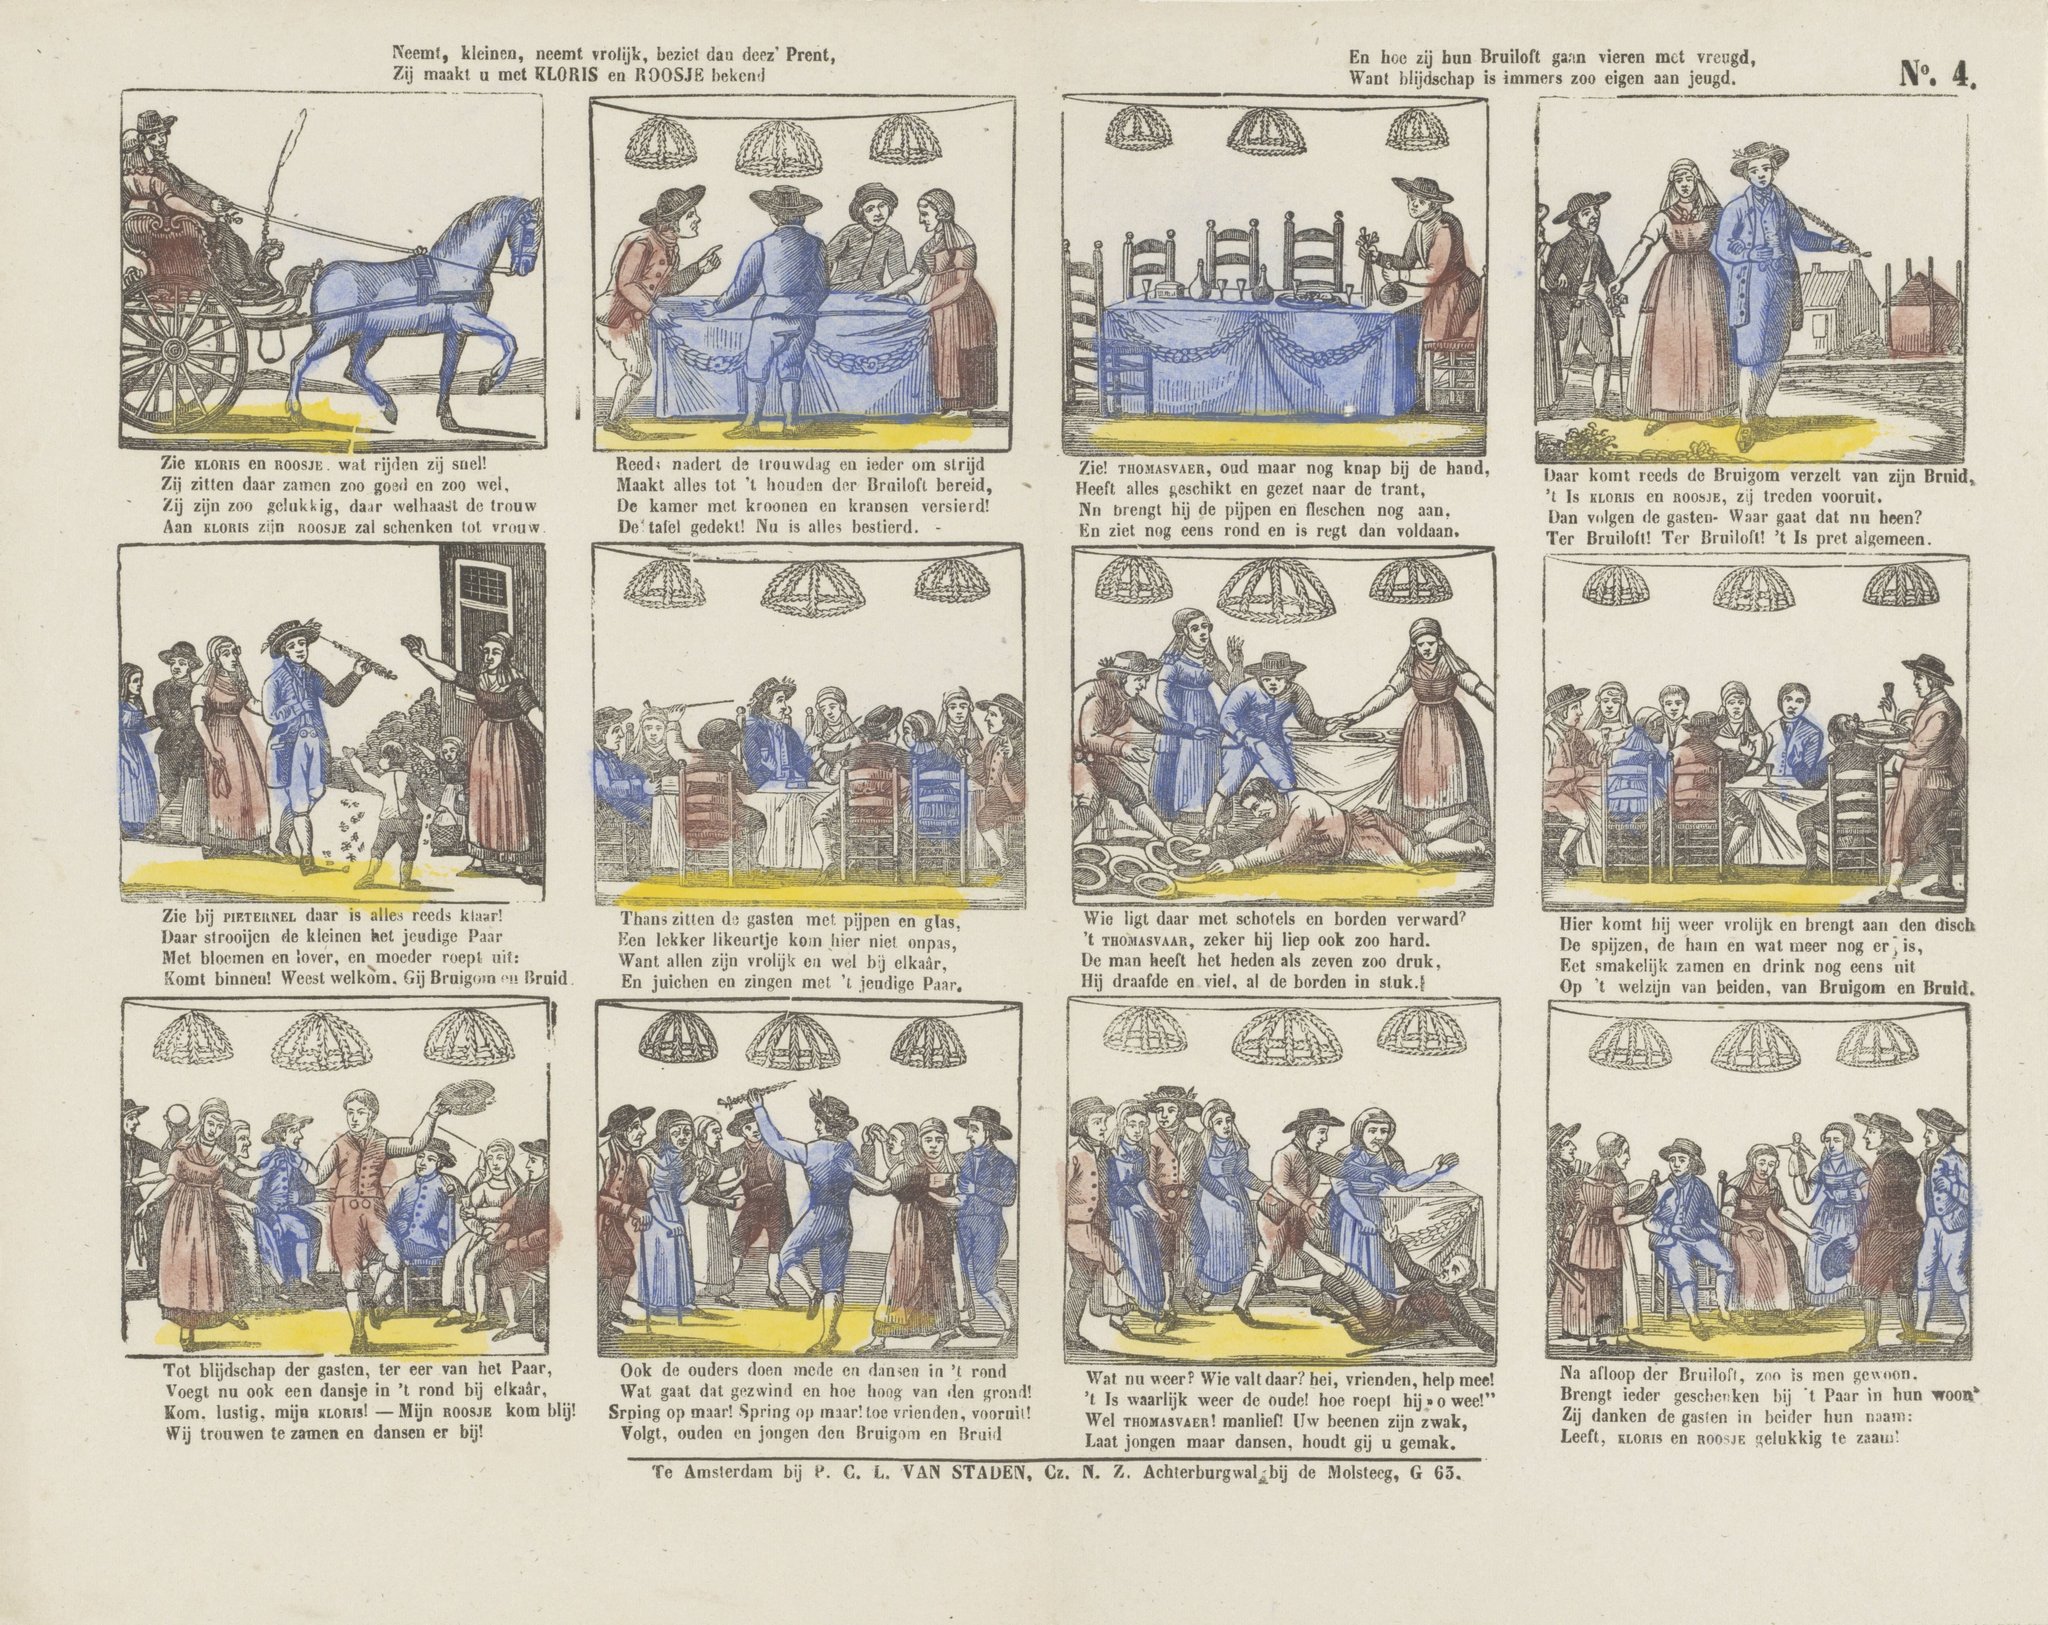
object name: print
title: Neemt, kleinen, neemt vrolijk, beziet deze prent, / Zij maakt u met Kloris en Roosje bekend, / En hoe zij hun bruiloft gaan vieren met vreugd, / Want blijdschap is immers zoo eigen aan jeugd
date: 1850-1870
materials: paper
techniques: colour, letterpress printing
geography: netherlands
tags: wedding feast, wedding meal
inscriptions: collector's mark: Lugt 2760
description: Blad met 12 voorstellingen over de bruiloft van Kloris en Roosje. Onder elke afbeelding een vierregelig vers. Rechtsboven genummerd: No. 4.